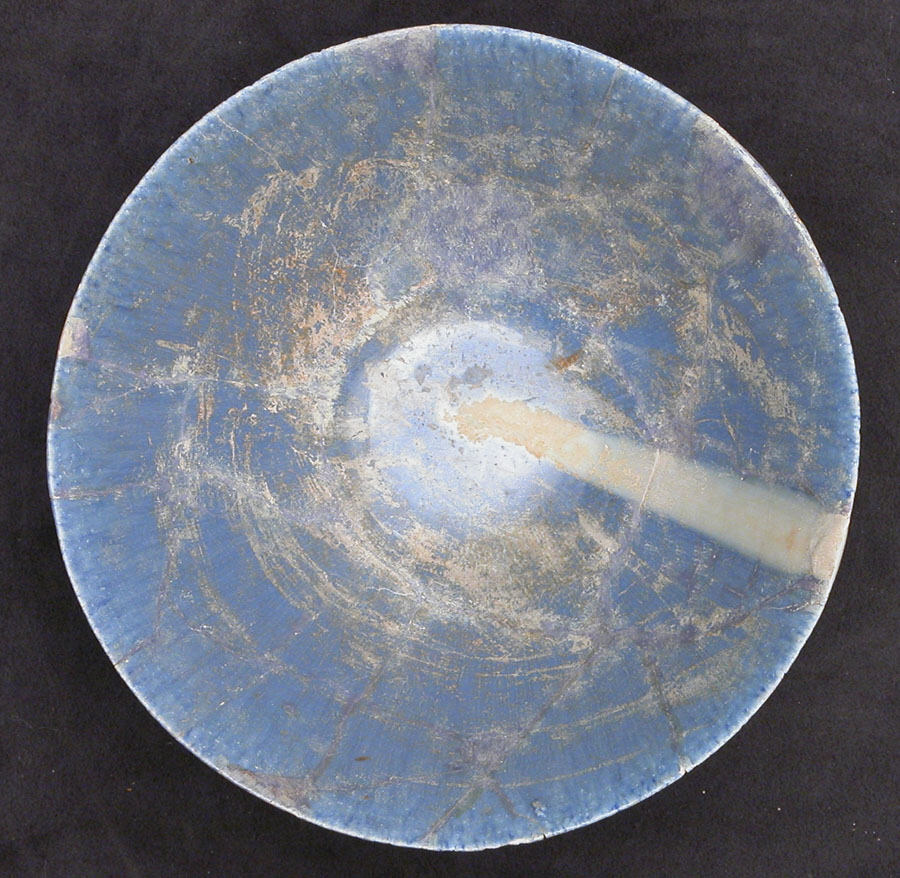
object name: bowl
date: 1101-1200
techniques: glazing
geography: iran